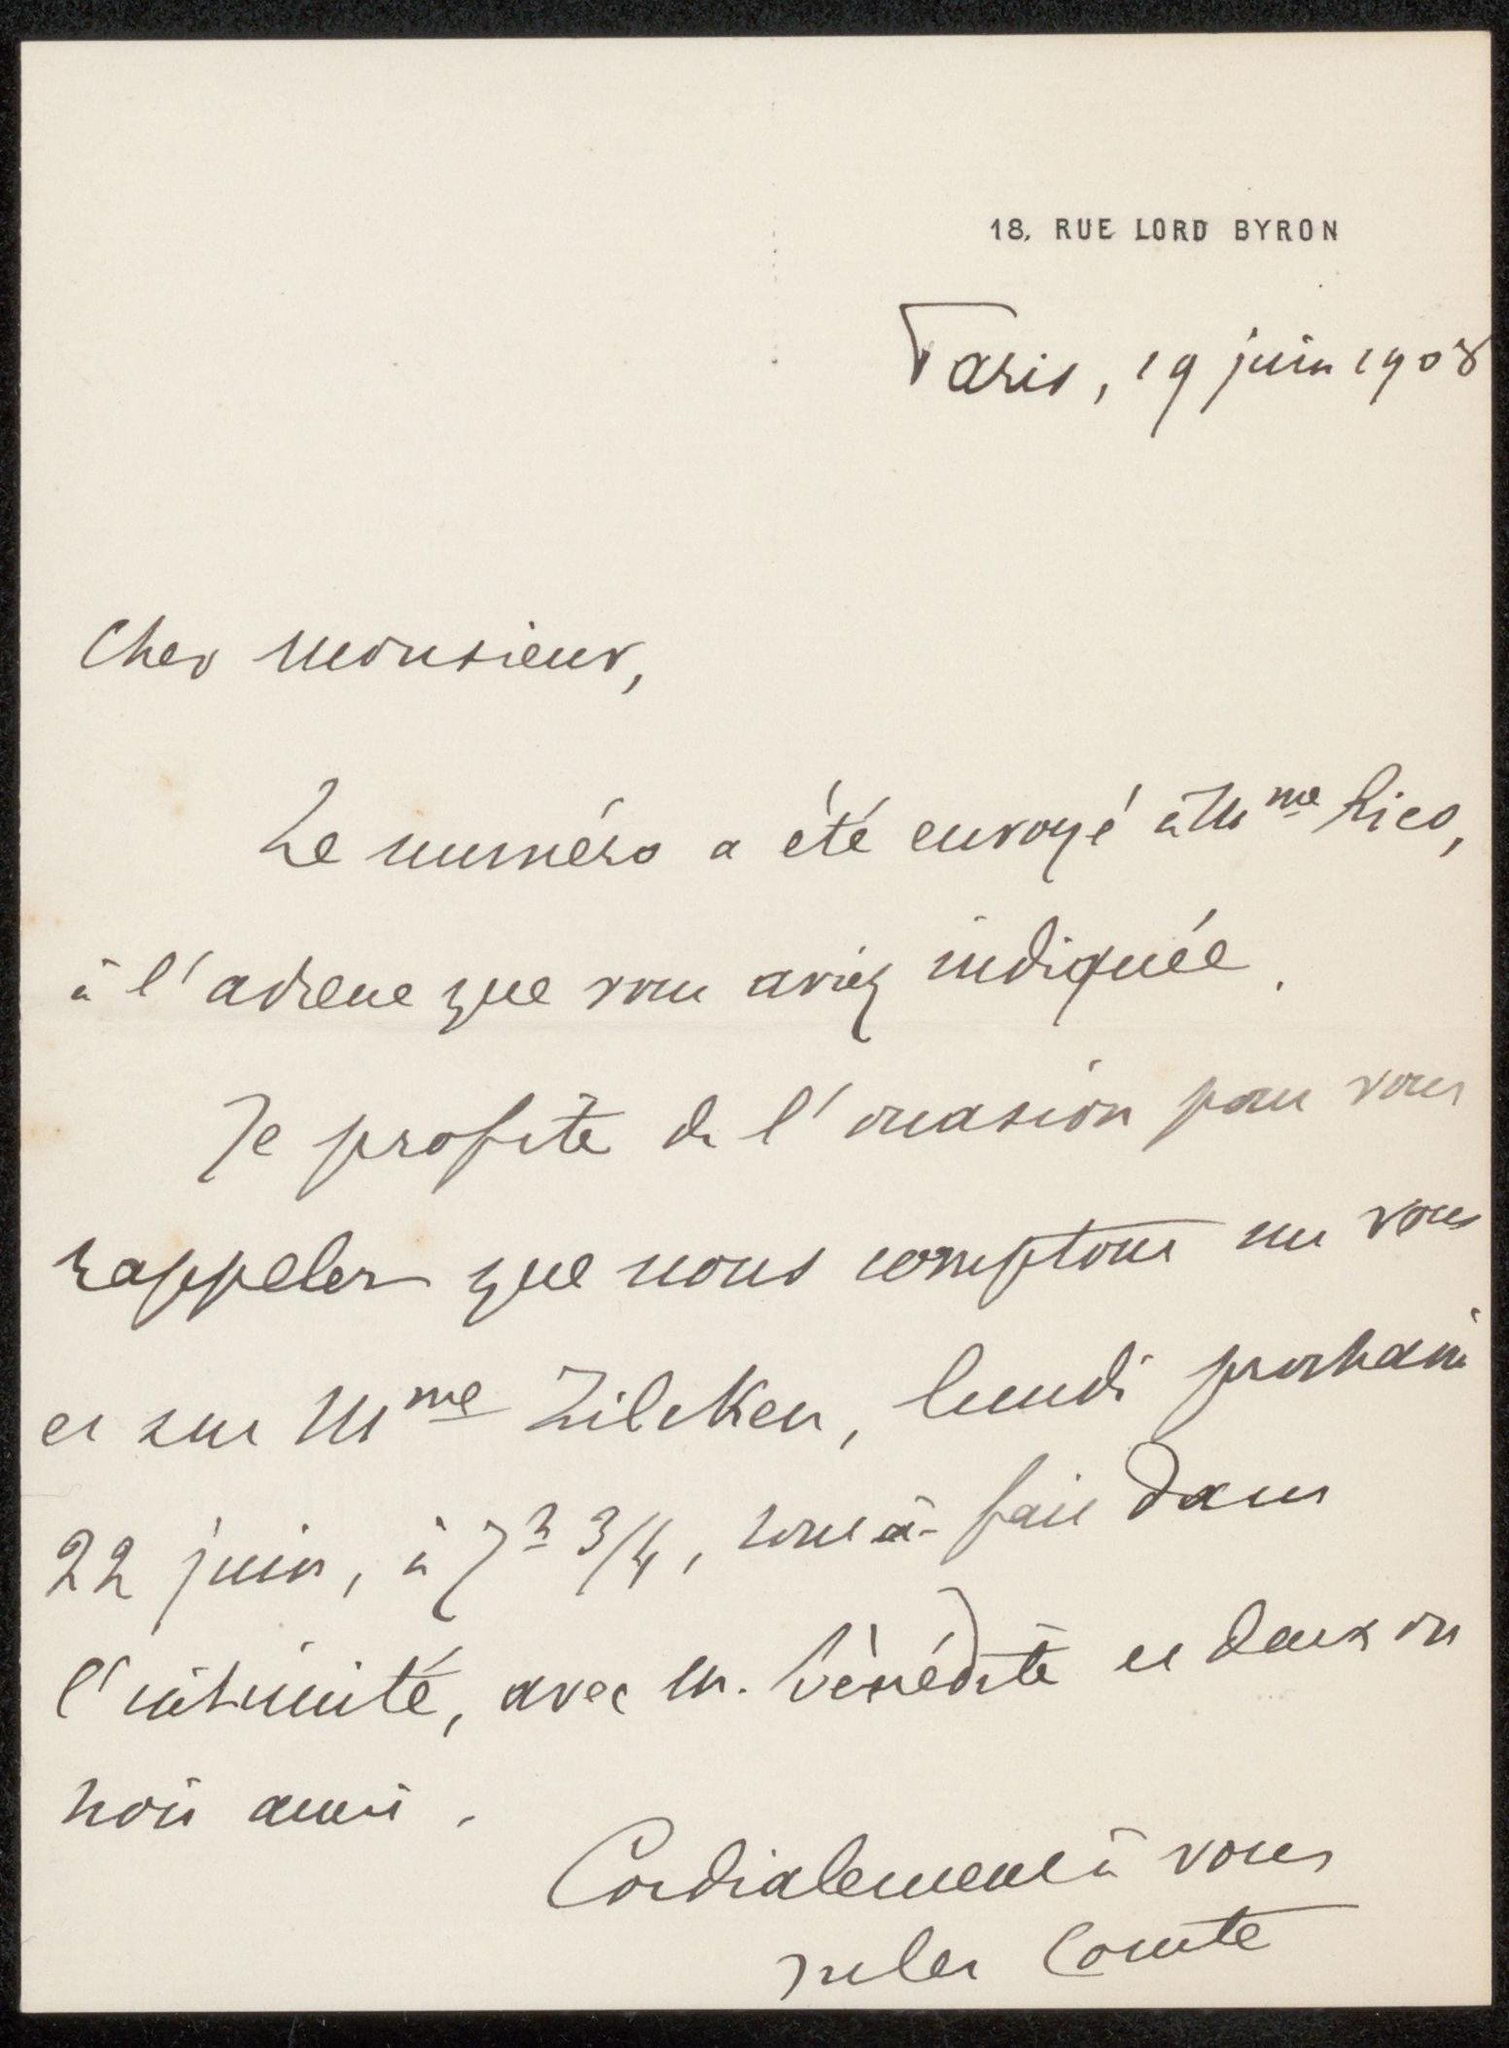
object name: letter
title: Brief aan Philip Zilcken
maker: jules comte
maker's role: official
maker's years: 1846-1912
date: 1908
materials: ink, paper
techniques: pen, printing, writing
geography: paris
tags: paris, léonce bénédite, the hague, painter, philip zilcken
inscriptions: watermark, collector's mark: ‘RPK’